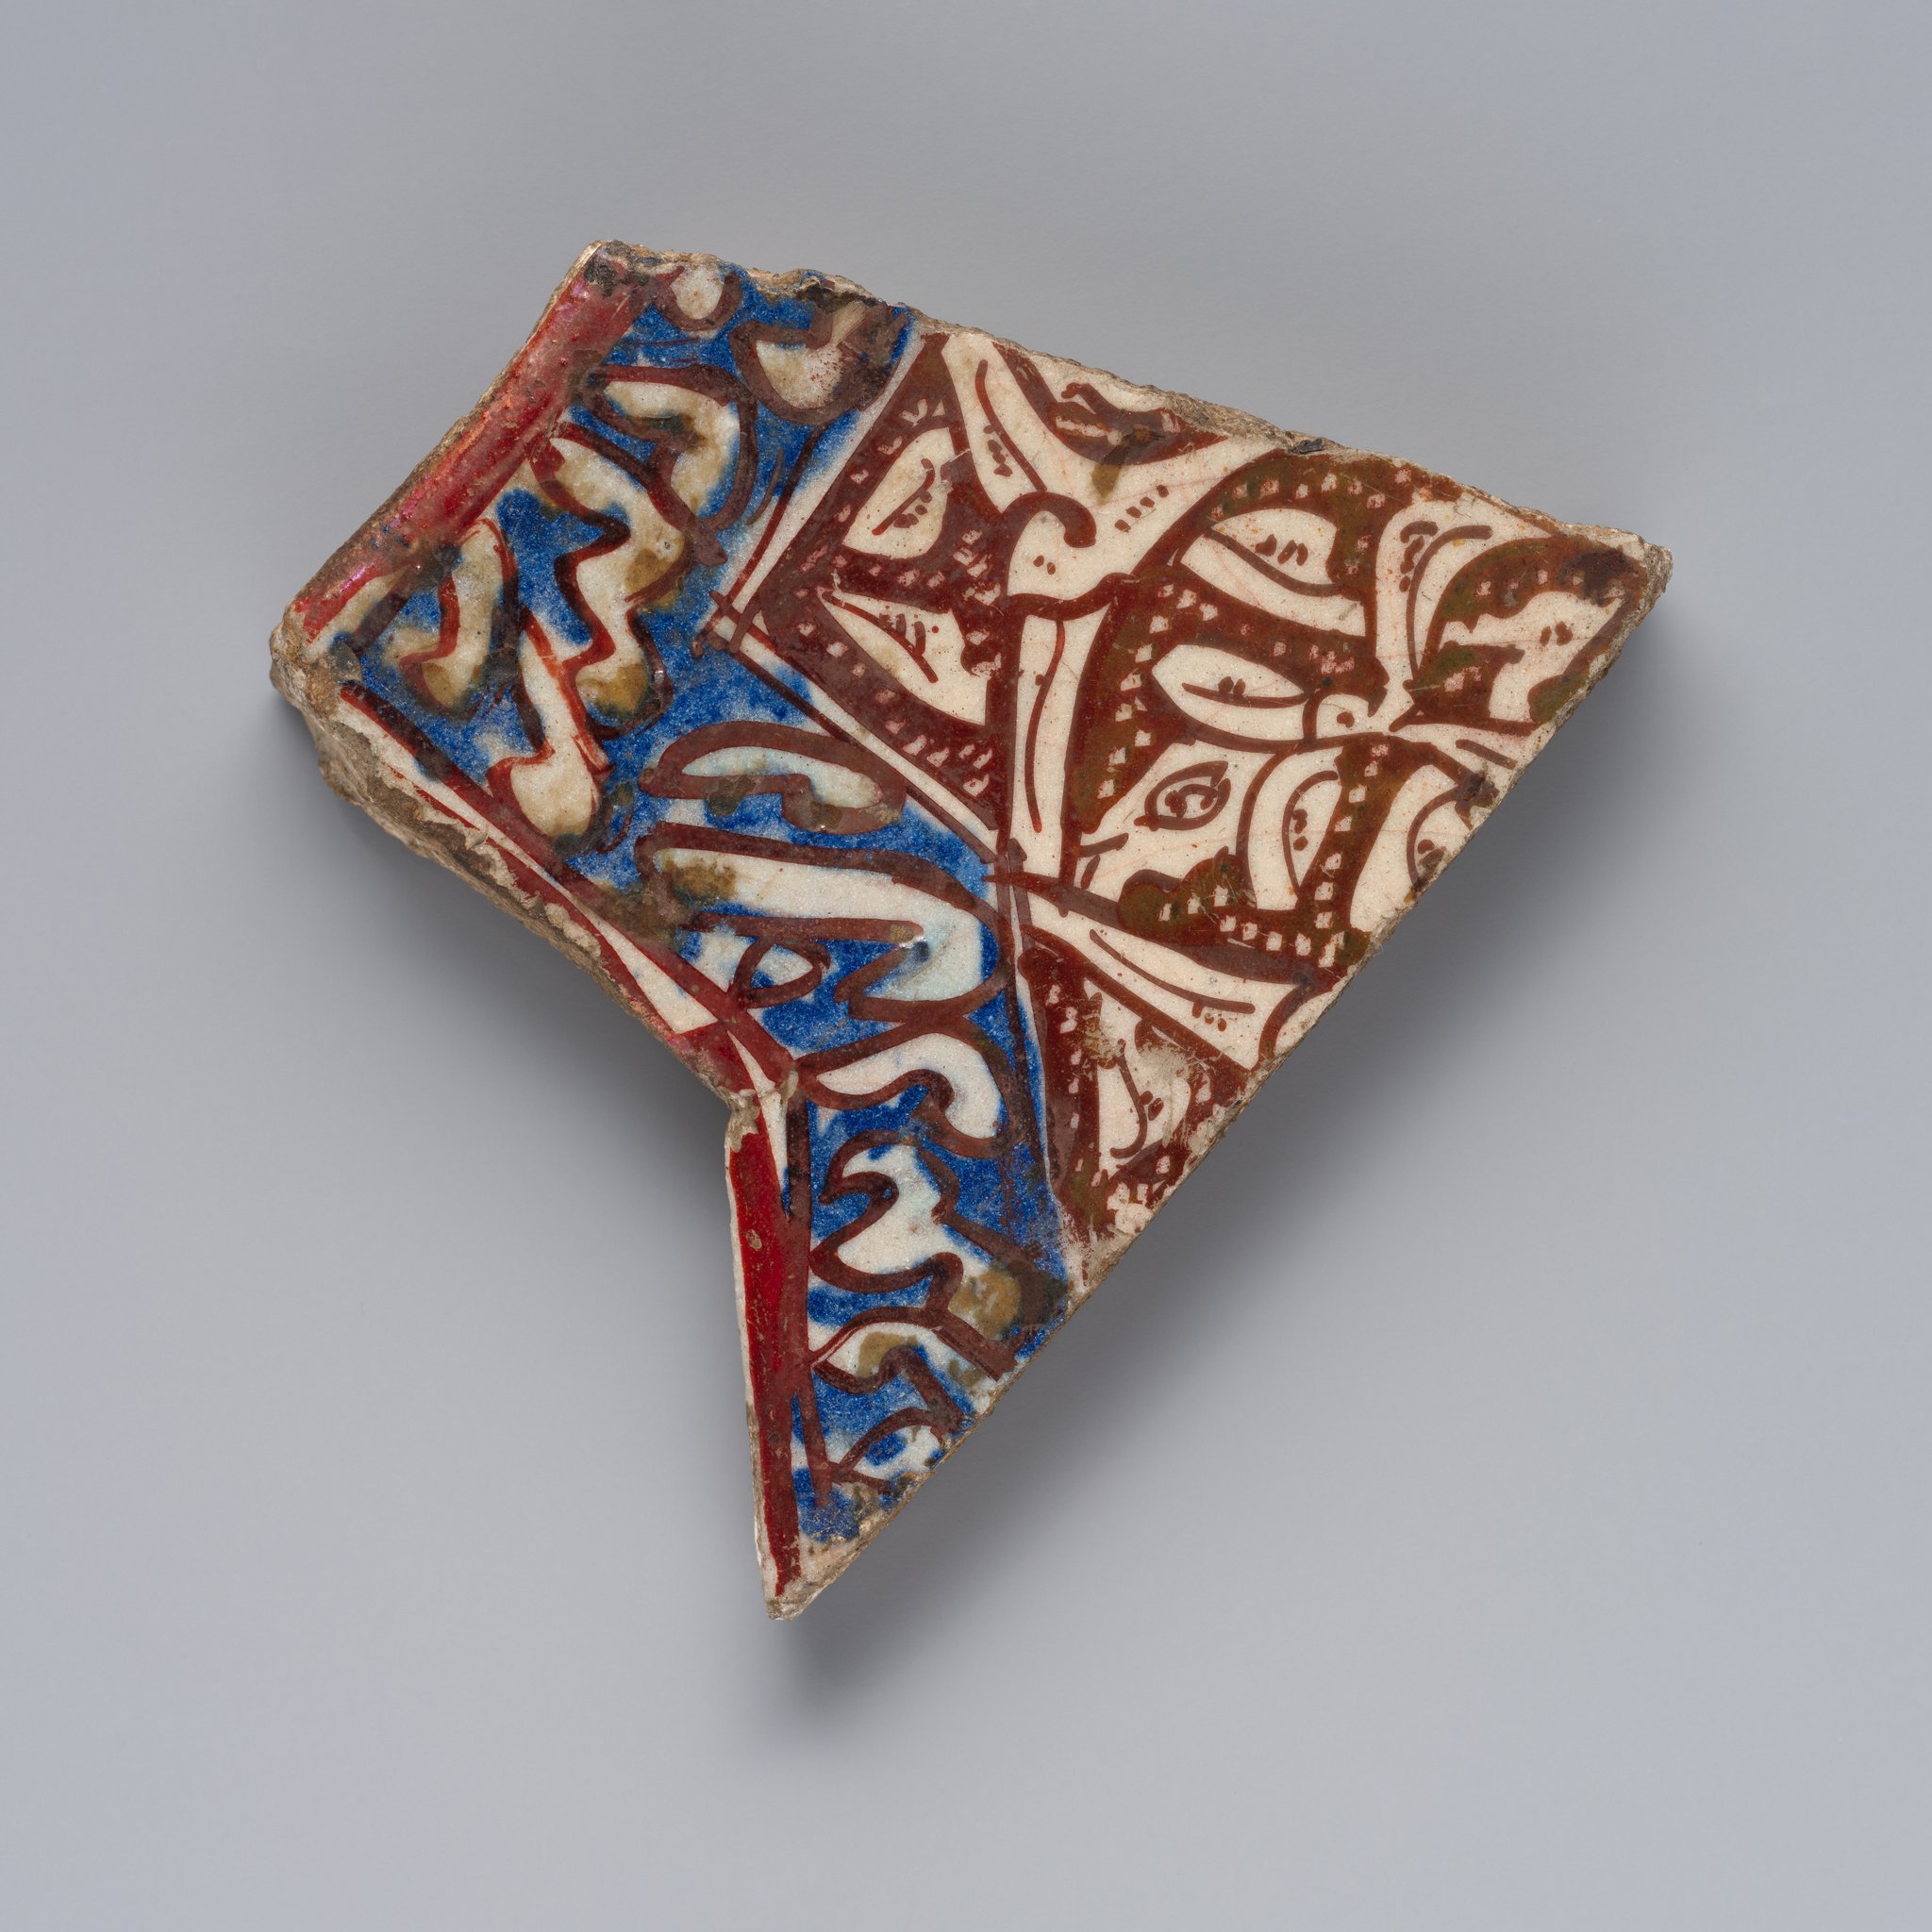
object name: tile fragment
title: Fragment of a Star-Shaped Tile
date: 1301-1400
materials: stonepaste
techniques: glazing, luster painting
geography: iran